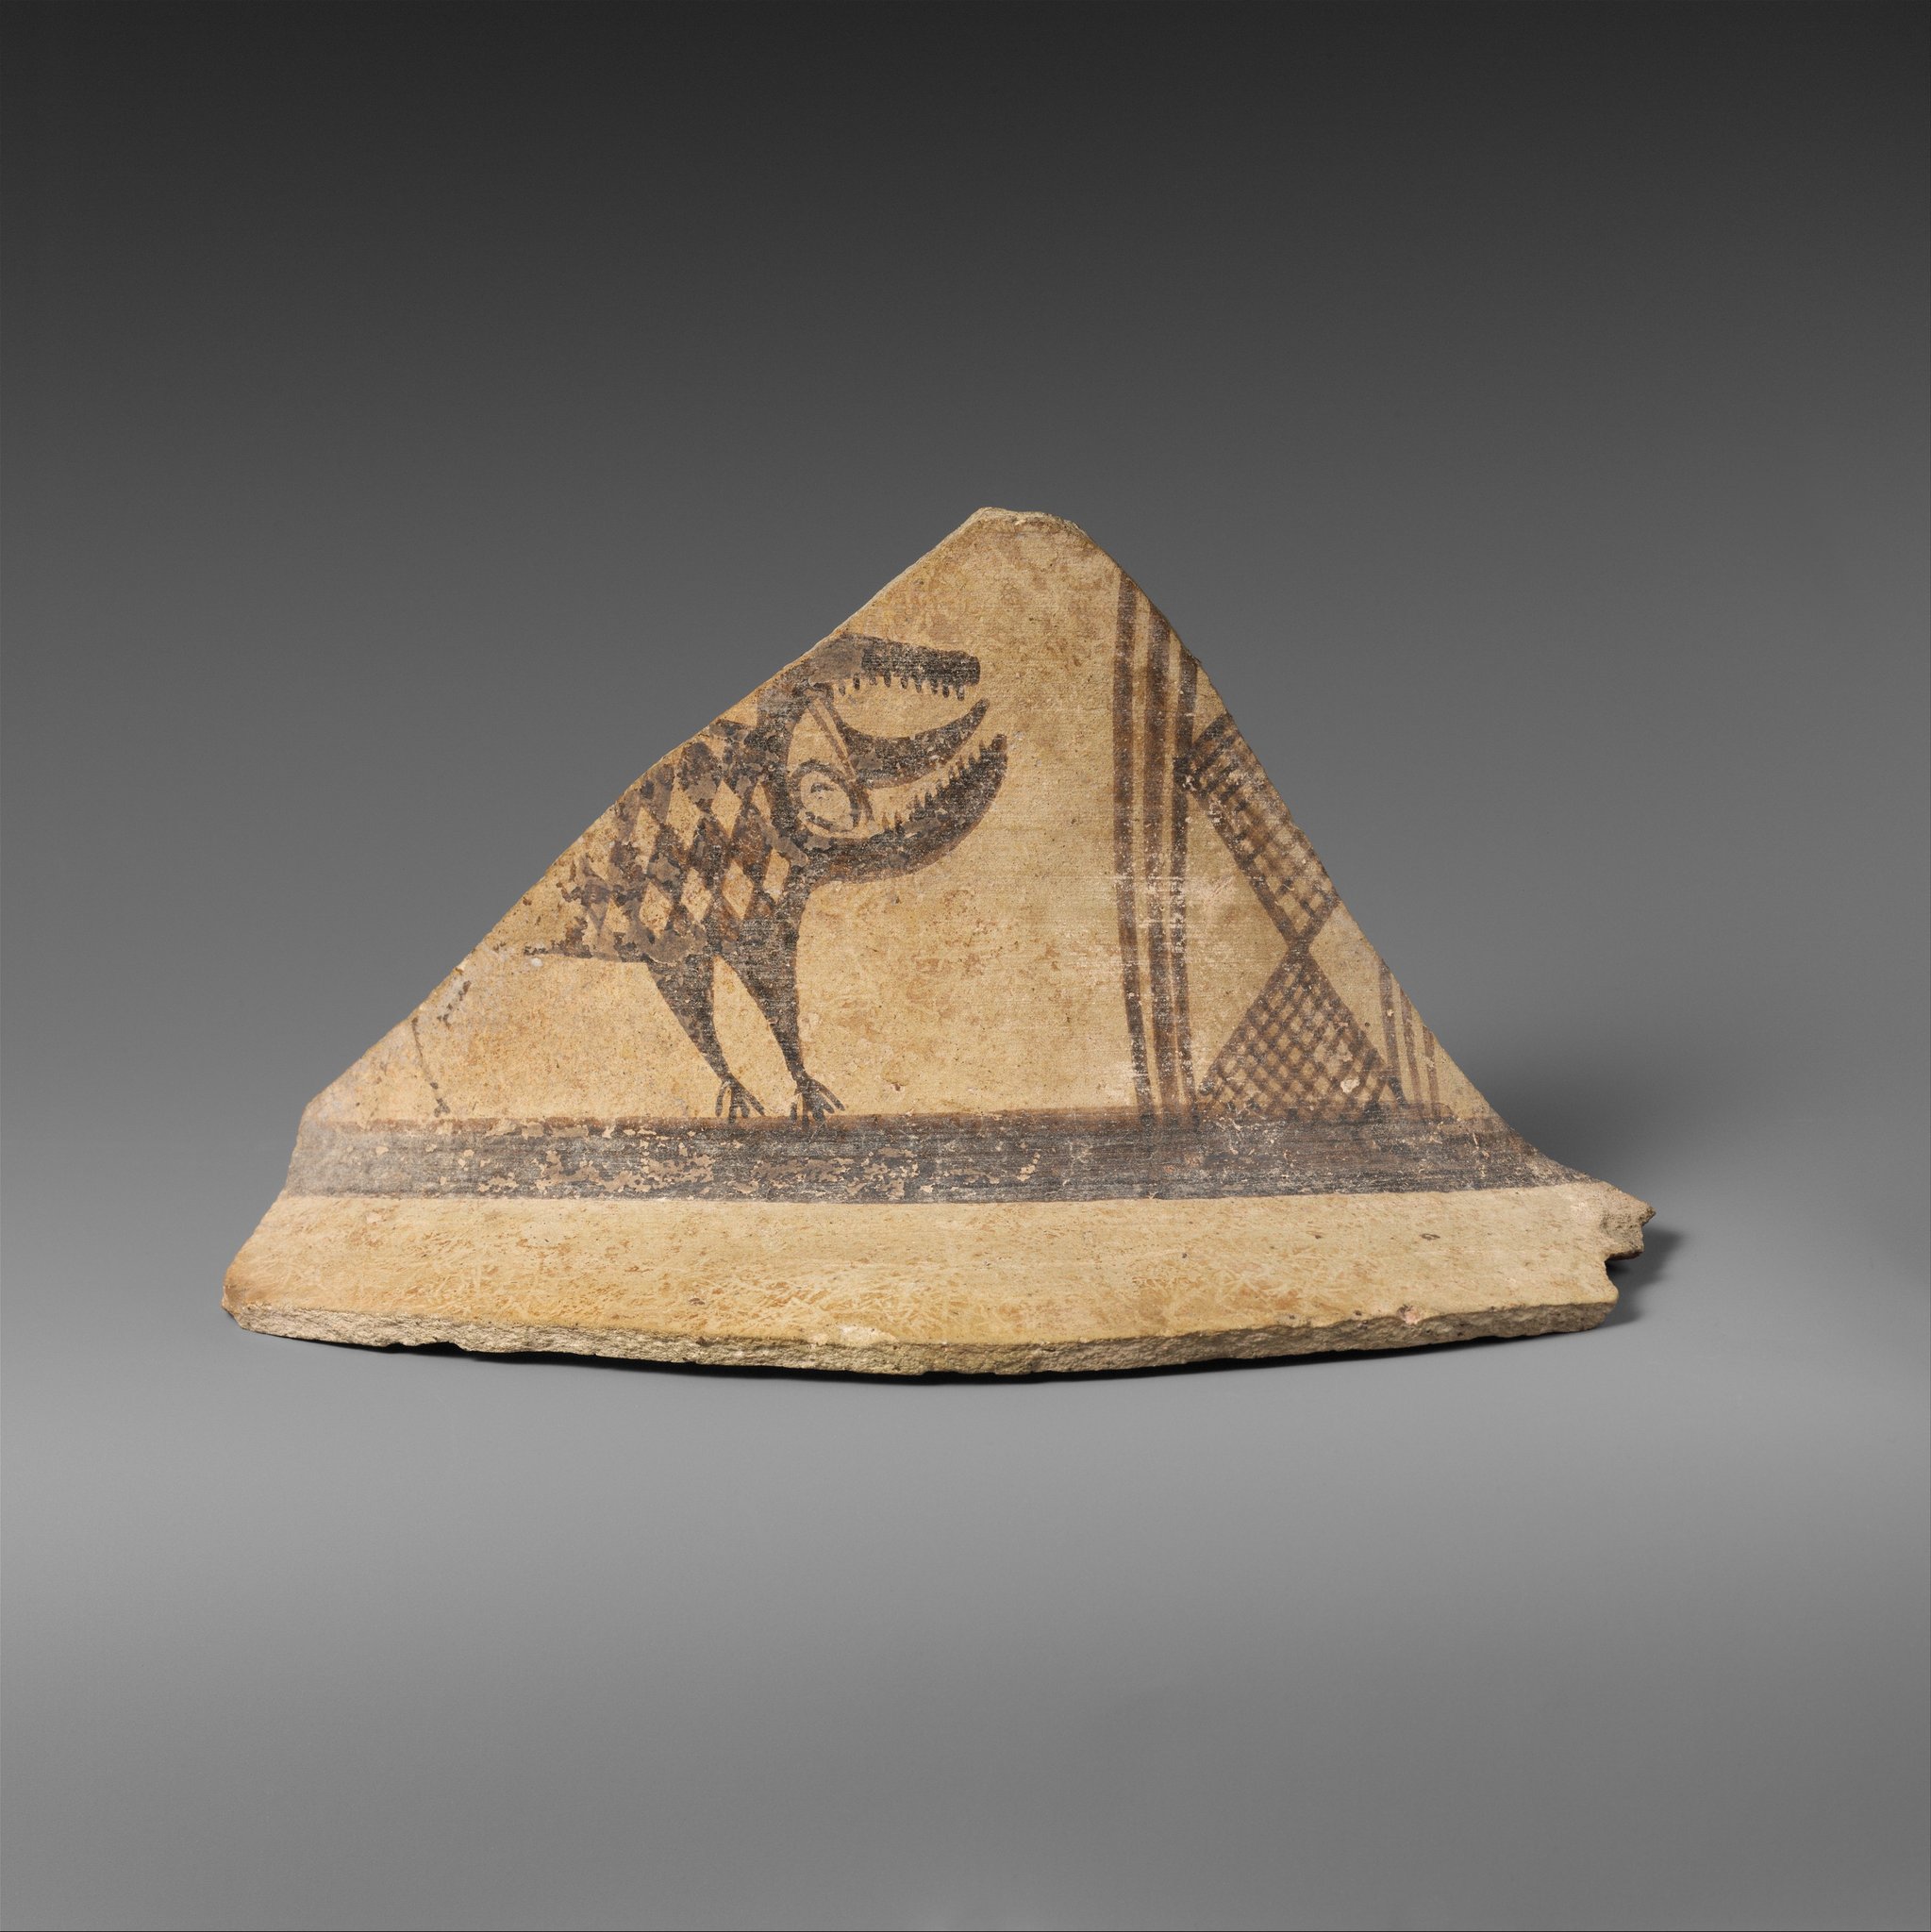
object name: amphora fragment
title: Fragment from the neck of a terracotta amphora (jar)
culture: cypriot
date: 850-750 BCE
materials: terracotta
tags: lions